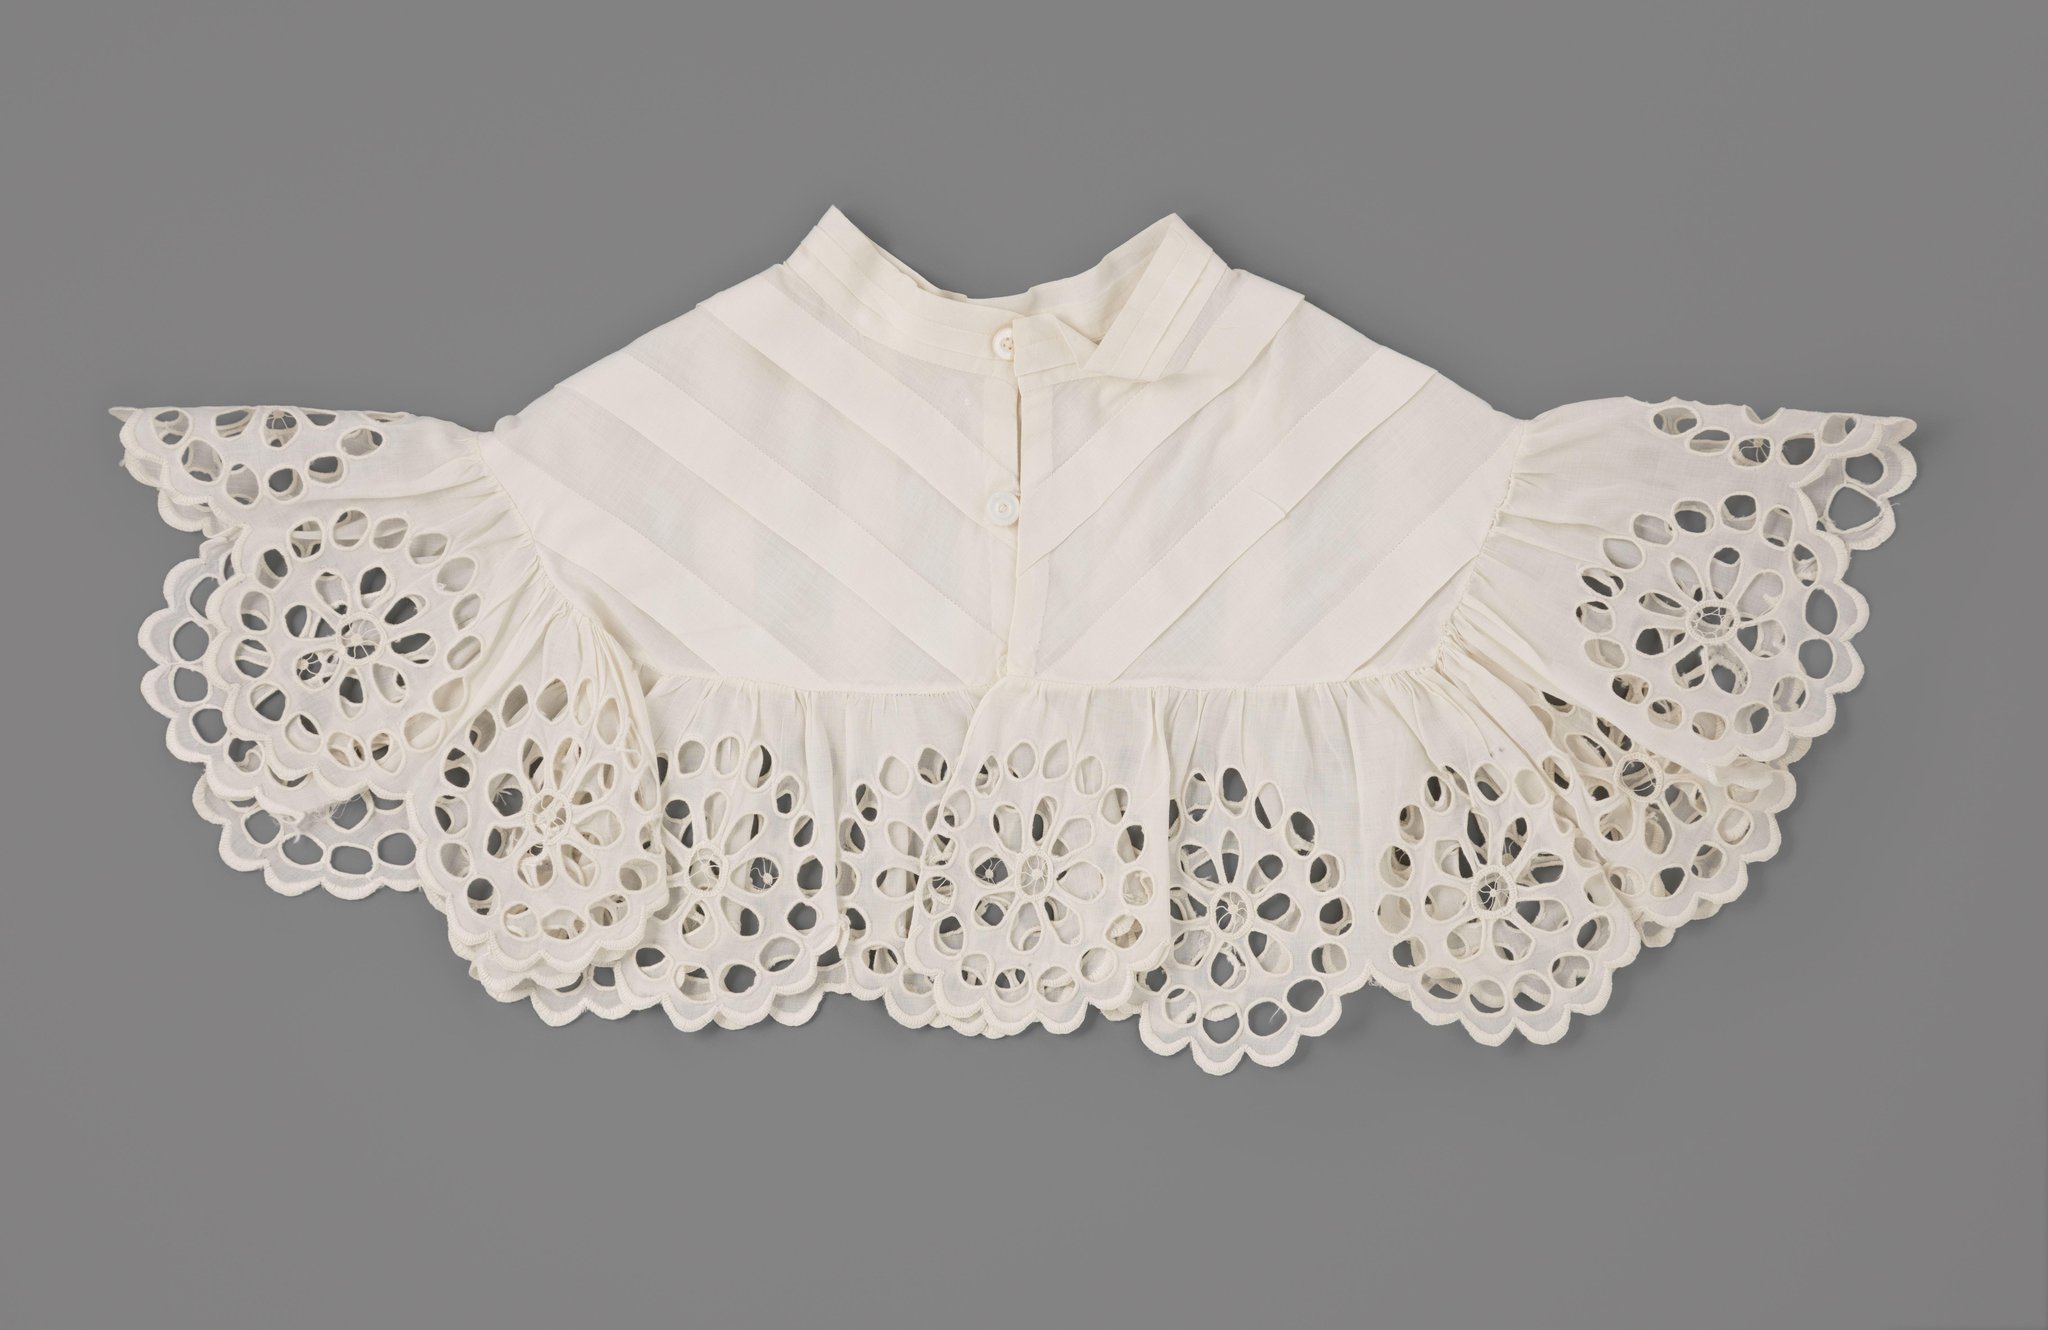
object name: womenswear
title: Kraag van batist afgezet met een schulprand die is versierd met Engels borduurwerk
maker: Anonymous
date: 1875-1925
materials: cotton, mother of pearl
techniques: english embroidery, festoon stitch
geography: western europe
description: Kraag van katoenbatist met opstaande boord en opgestikte stroken. De kraag is afgezet met een gerimpelde strook, die is versierd met Engels borduurwerk in de vorm van bloemen, en is afgezet met een gefestonneerde schulprand. De kraag sluit door middel van drie knopen op rij.